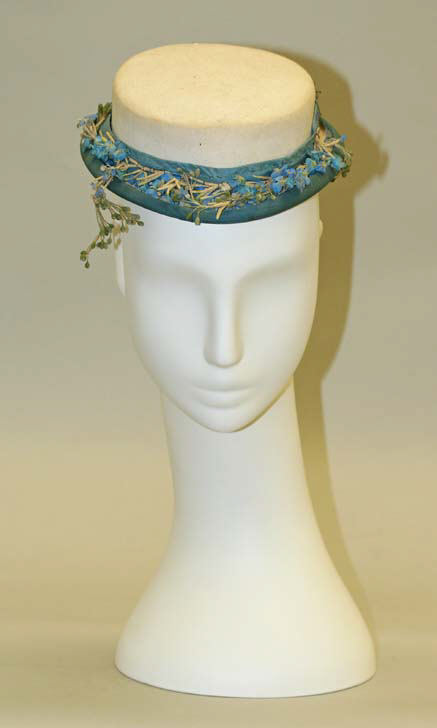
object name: promenade hat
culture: french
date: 1875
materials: silk, wool